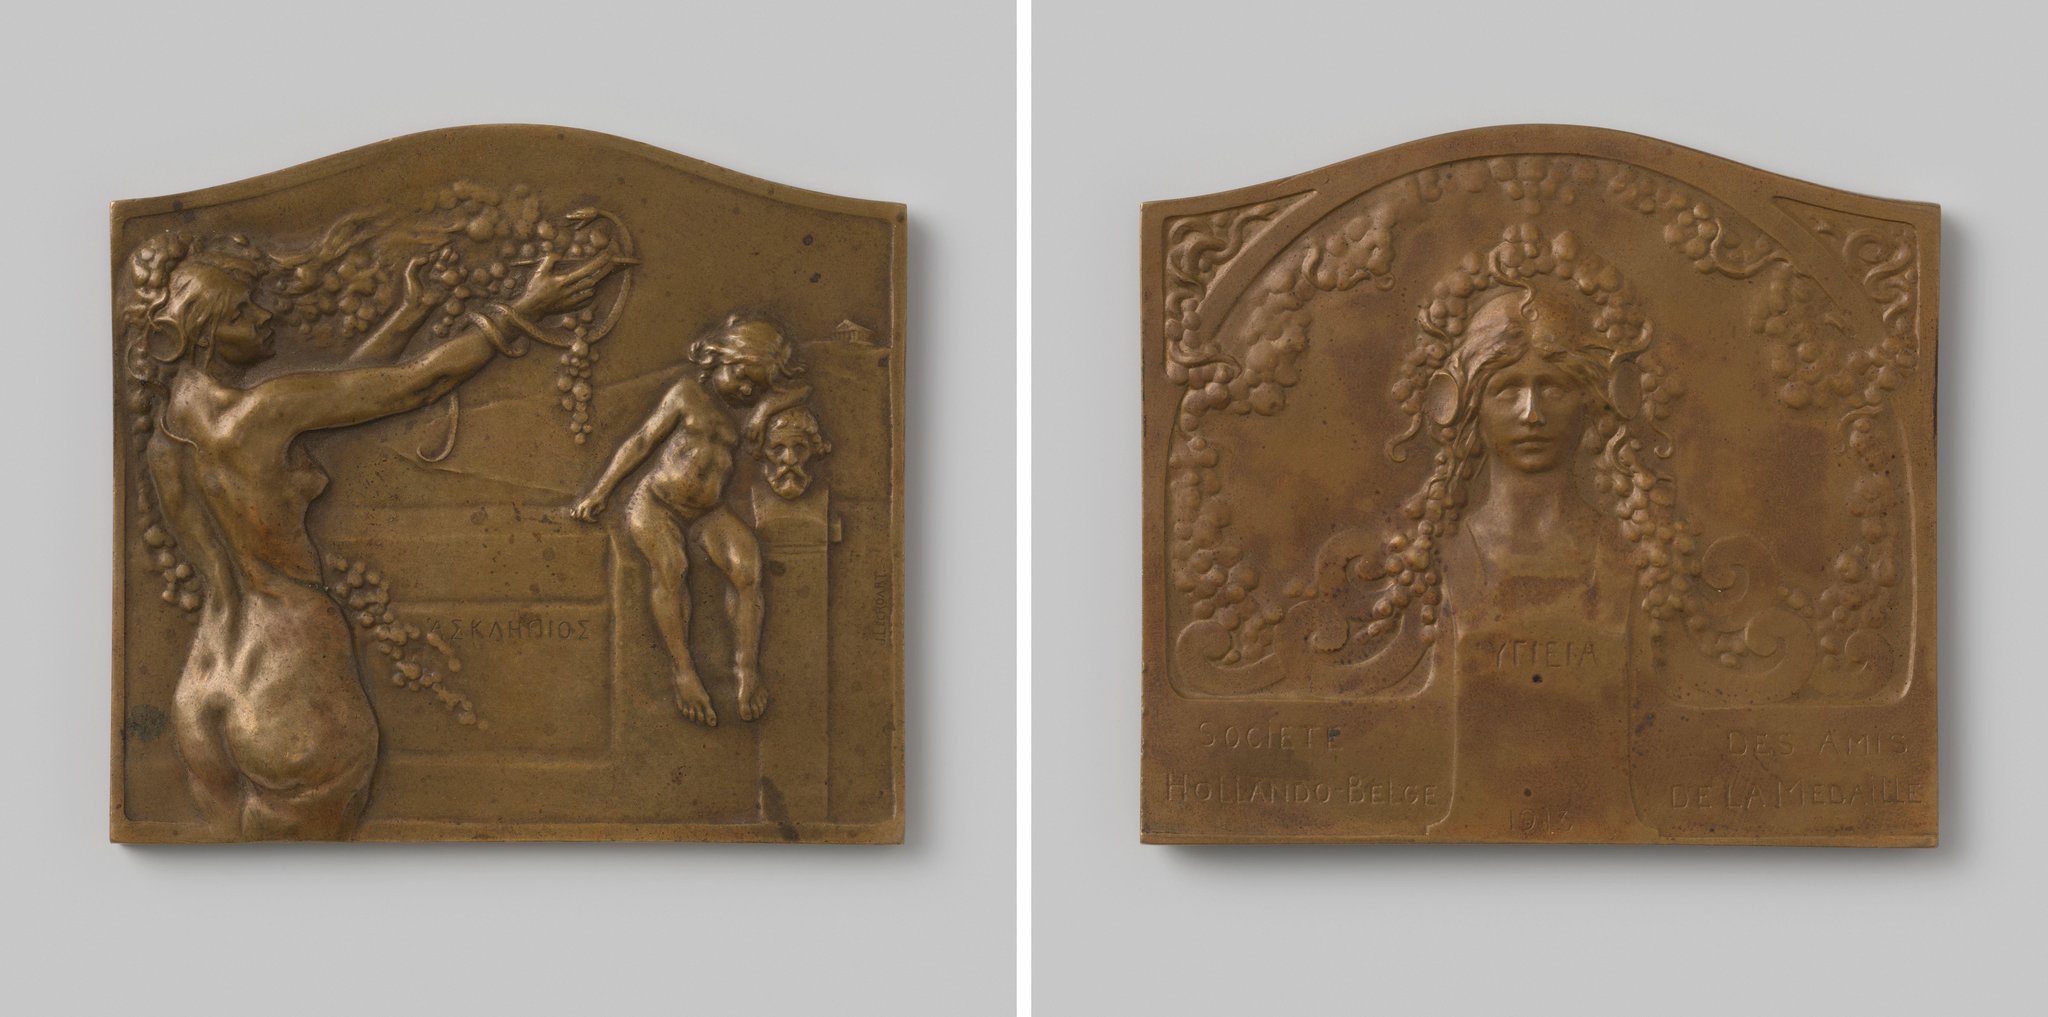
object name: medal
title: Asklepios / Hygieia 1913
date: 1913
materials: bronze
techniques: striking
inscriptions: : ‘PAUL FISCH’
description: Bronzen plaquette, rechthoekig met gewelfde bovenkant, op de voorzijde een vrouw met slang en druiven bij een meisje op een hek, leunend op een portretbuste, op de keerzijde een aanziend borstbeeld op sokkel van Hygieia binnen een met bloemen versierde boog.